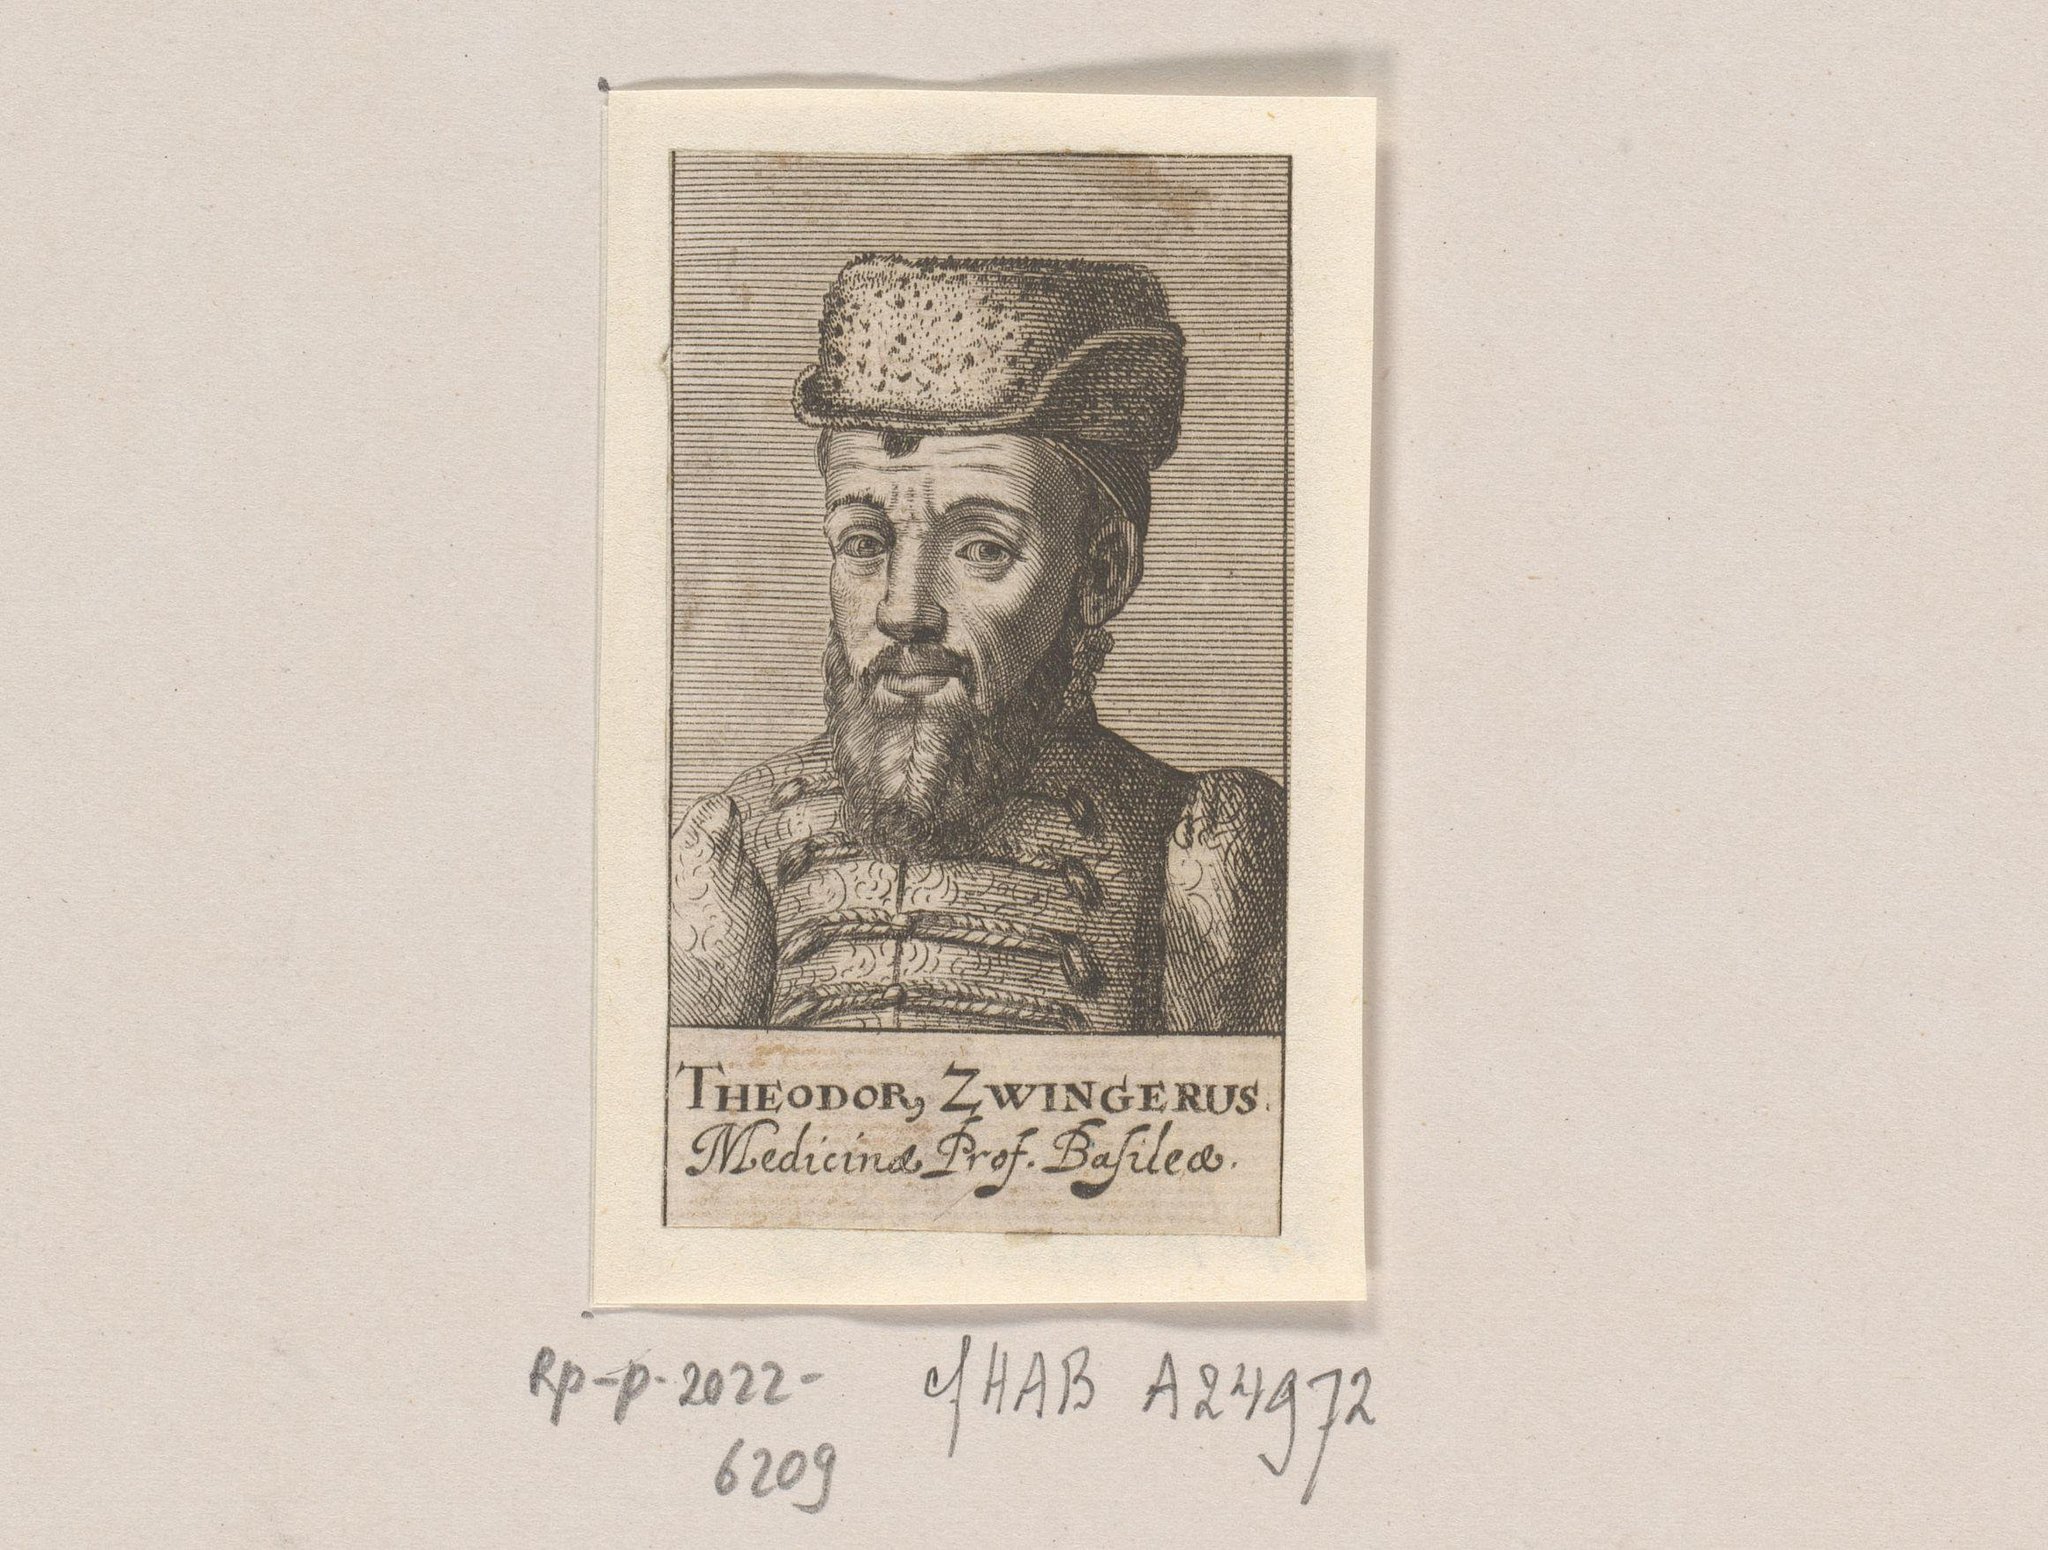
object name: print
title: Portret van Theodor Zwinger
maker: Anonymous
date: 1688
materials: paper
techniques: engraving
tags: scholar, philosopher, historical persons, physician, doctor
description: Prent waarschijnlijk uit: Freher, Paul. Theatrum virorum eruditione clarorum. Neurenberg: Johann Hoffmann, 1688.